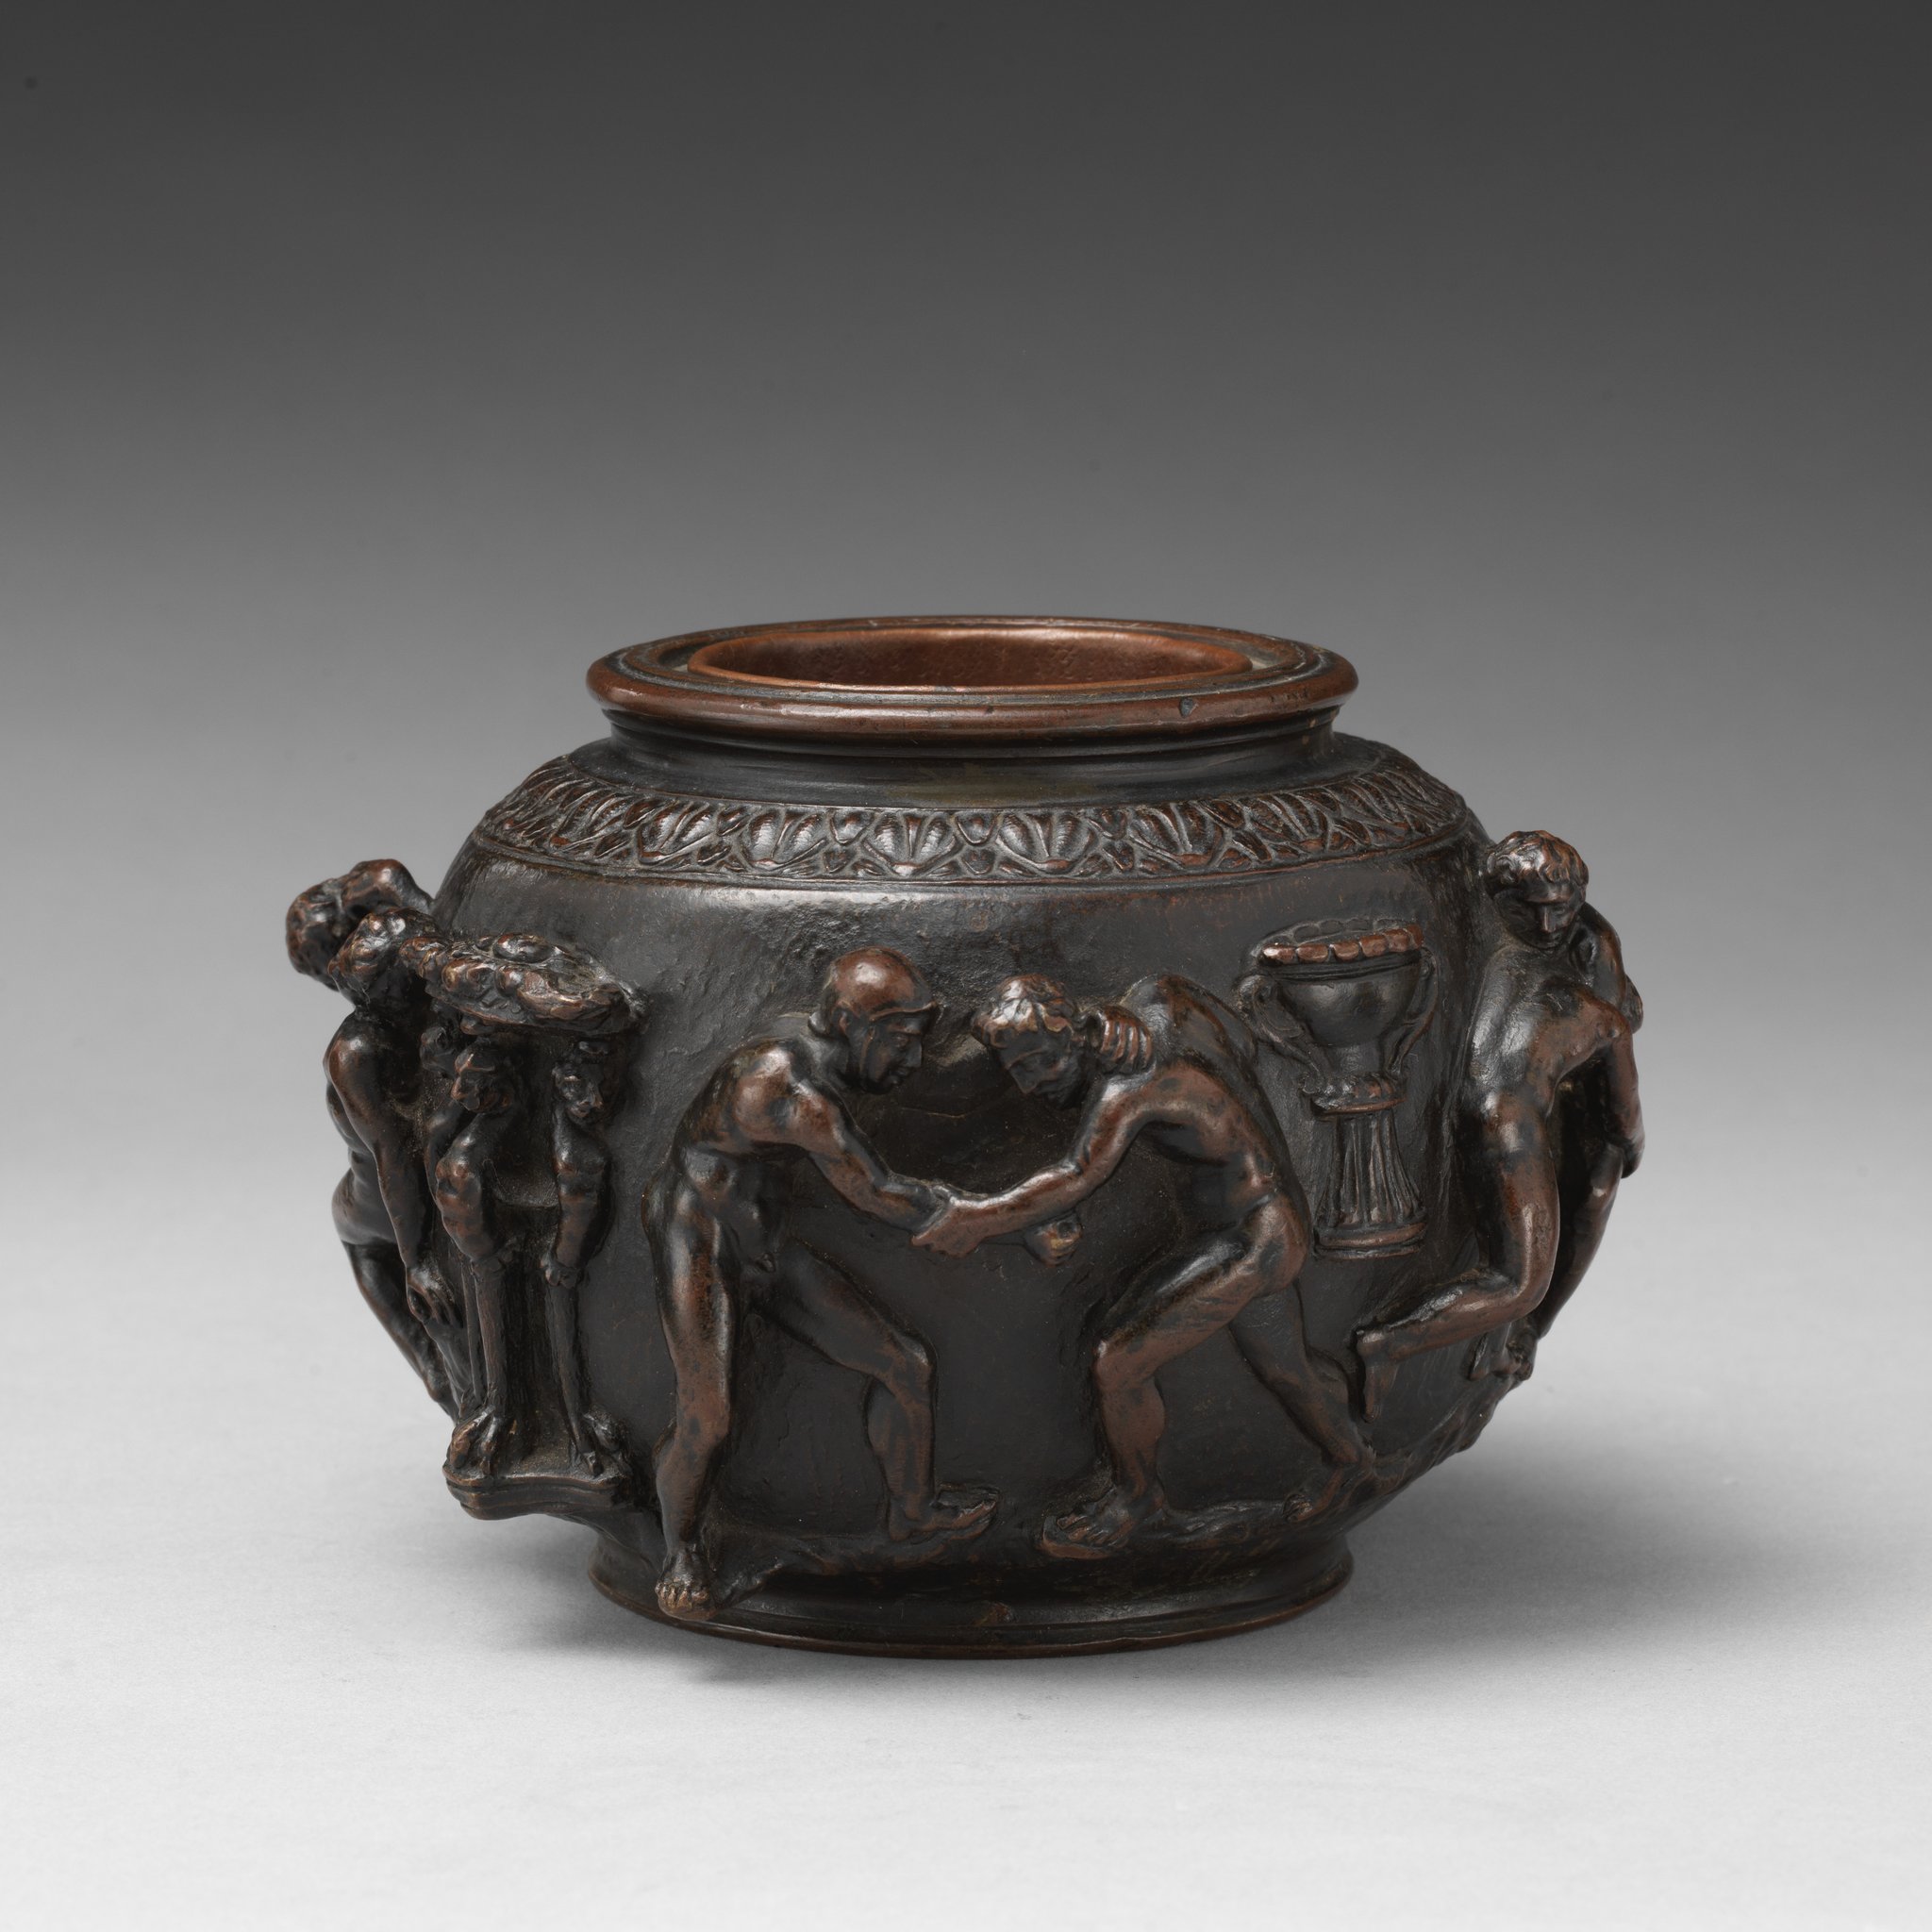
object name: vase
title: Vase with scenes of wrestling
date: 1701-1900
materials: bronze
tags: men,male nudes,plants